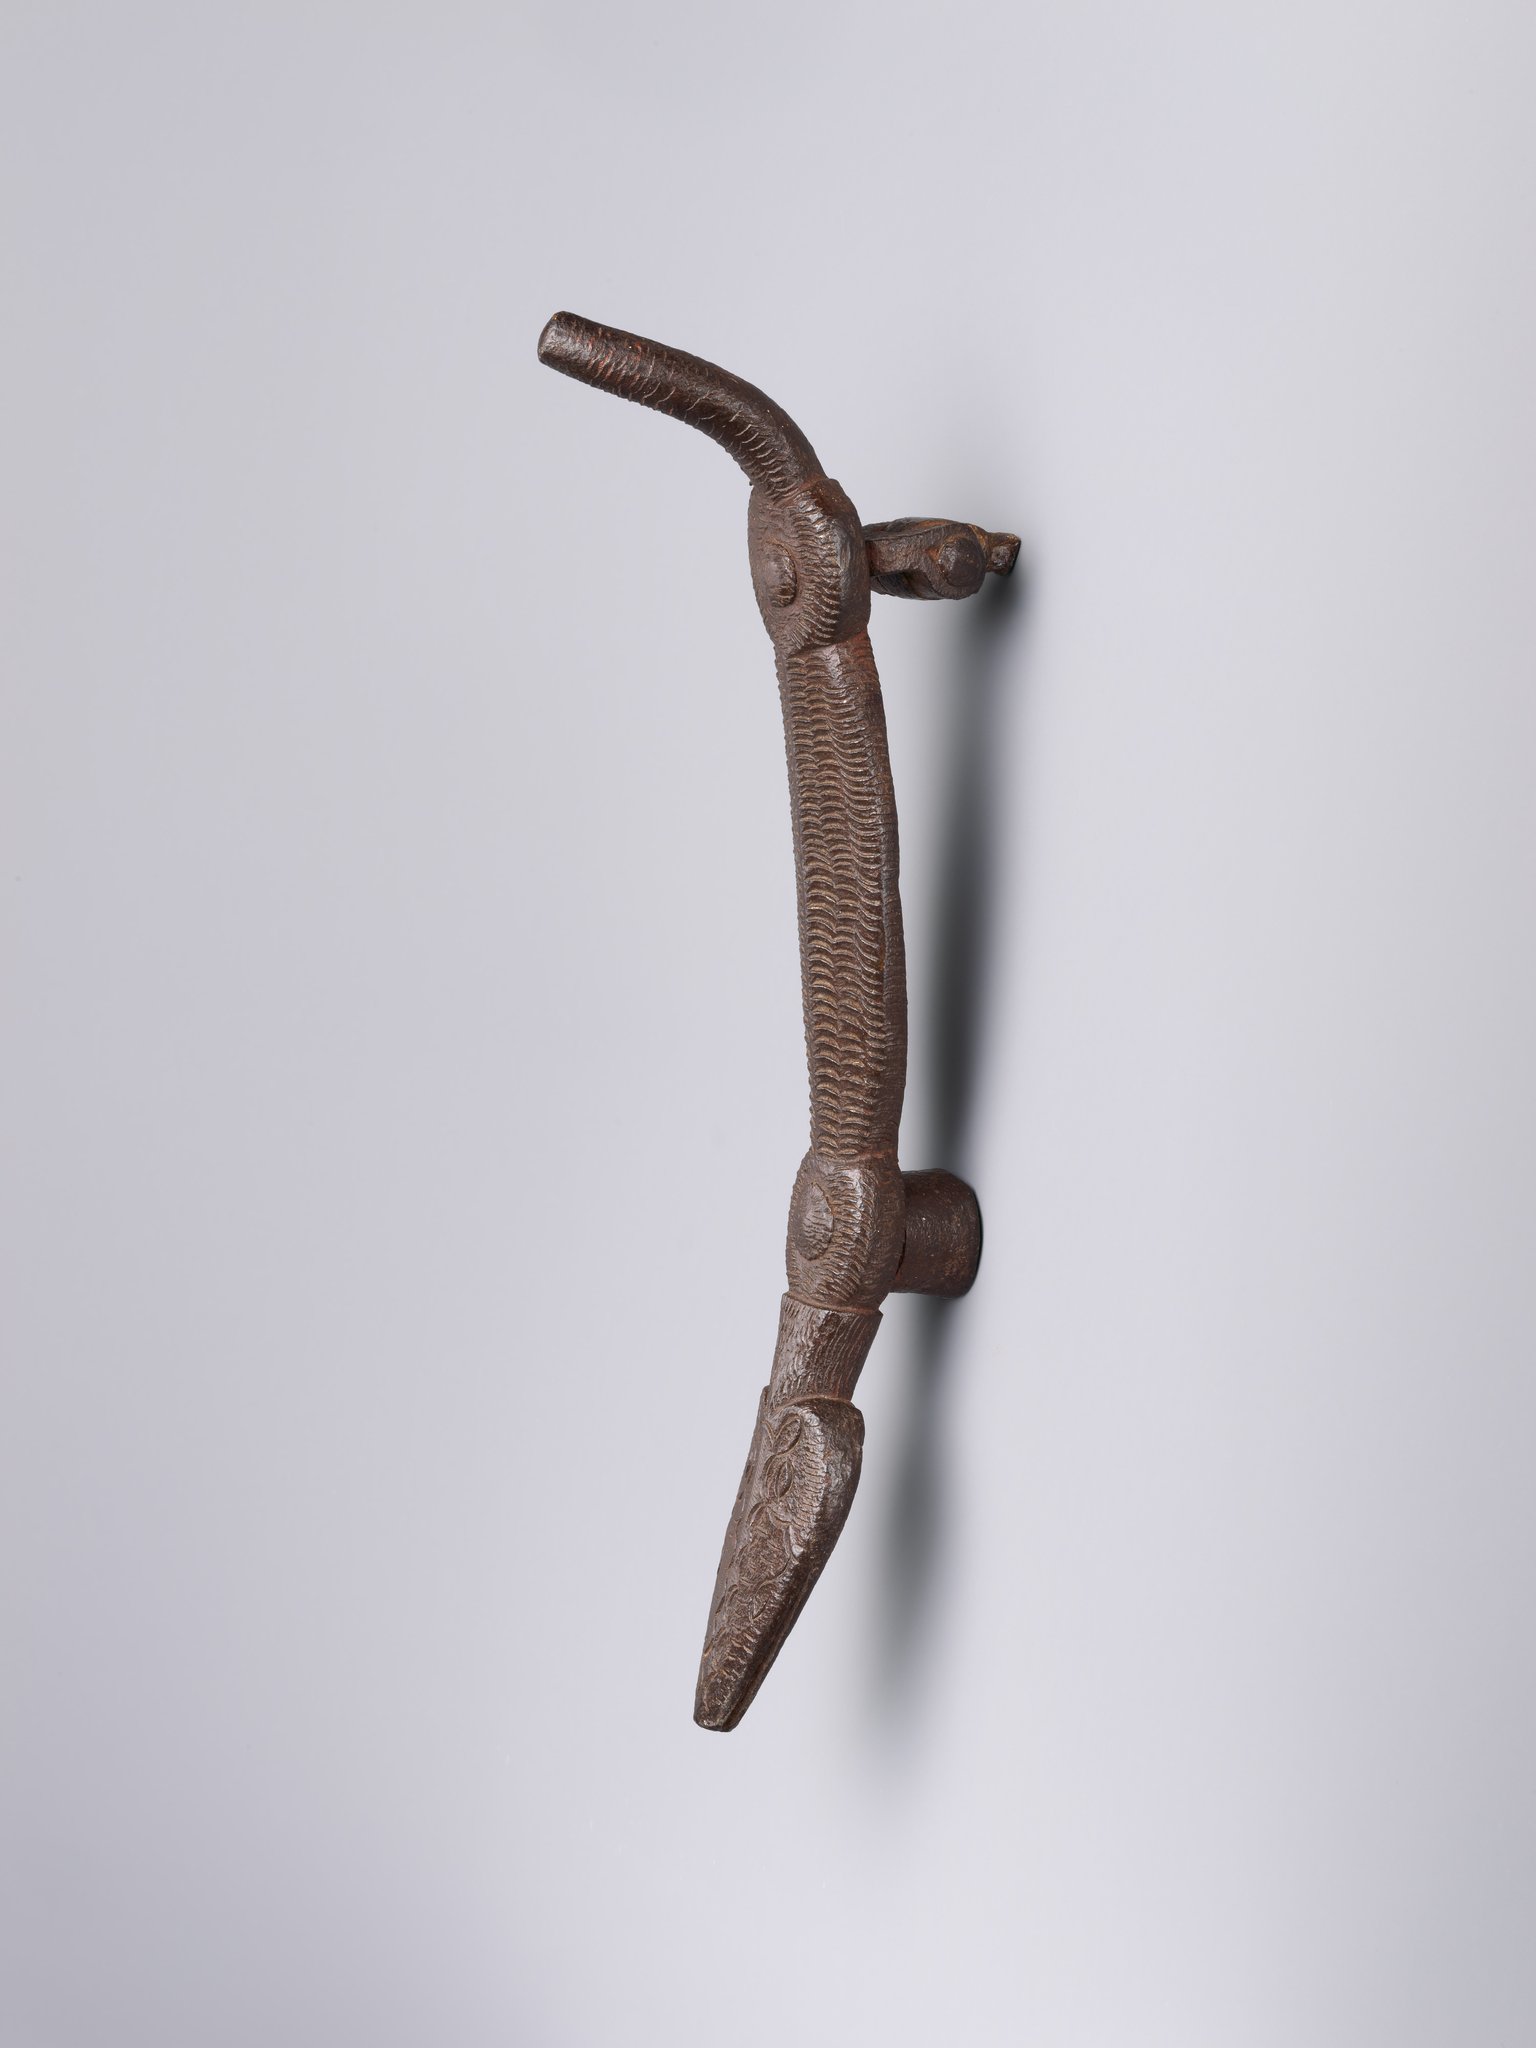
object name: door knocker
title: Door knocker in the shape of a crocodile-like creature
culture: spanish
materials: iron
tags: crocodiles